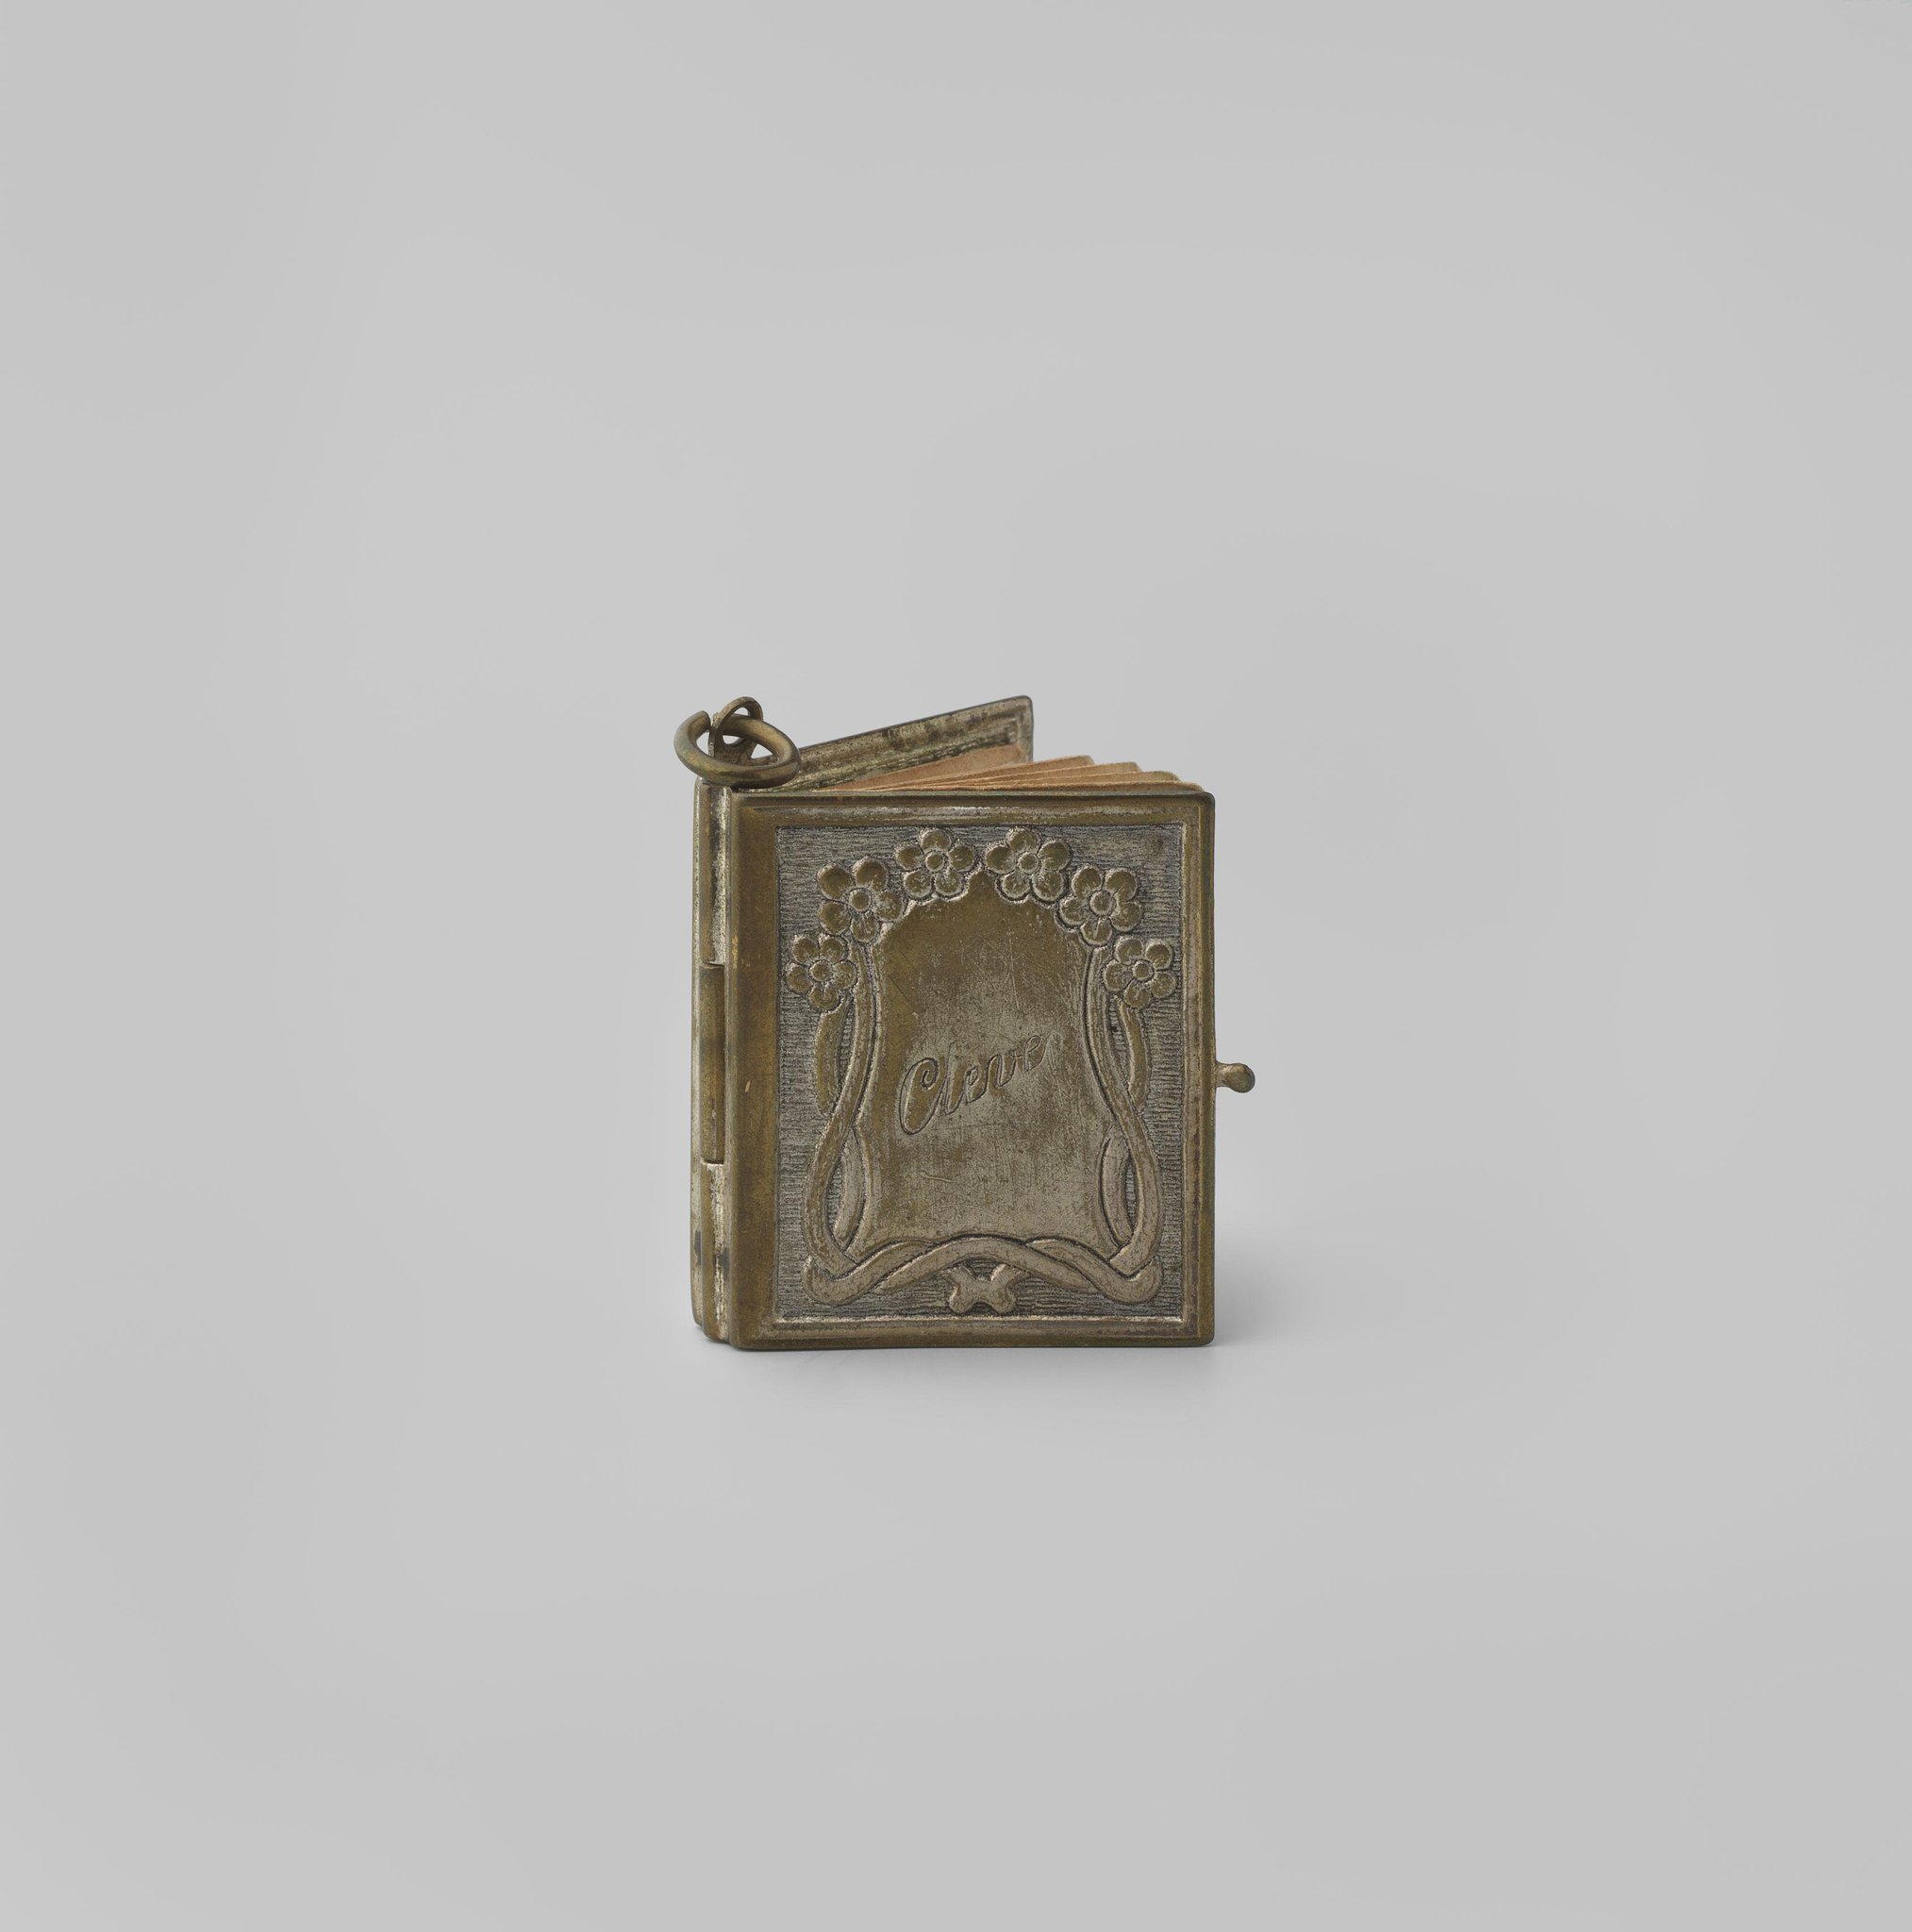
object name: charivari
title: Hanger met miniatuur leporelloalbum met tien foto's van Kleef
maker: Anonymous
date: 1880-1920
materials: photographic support, silver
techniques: gelatin silver print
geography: cleves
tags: prospect of city, town panorama, silhouette of city, cleves